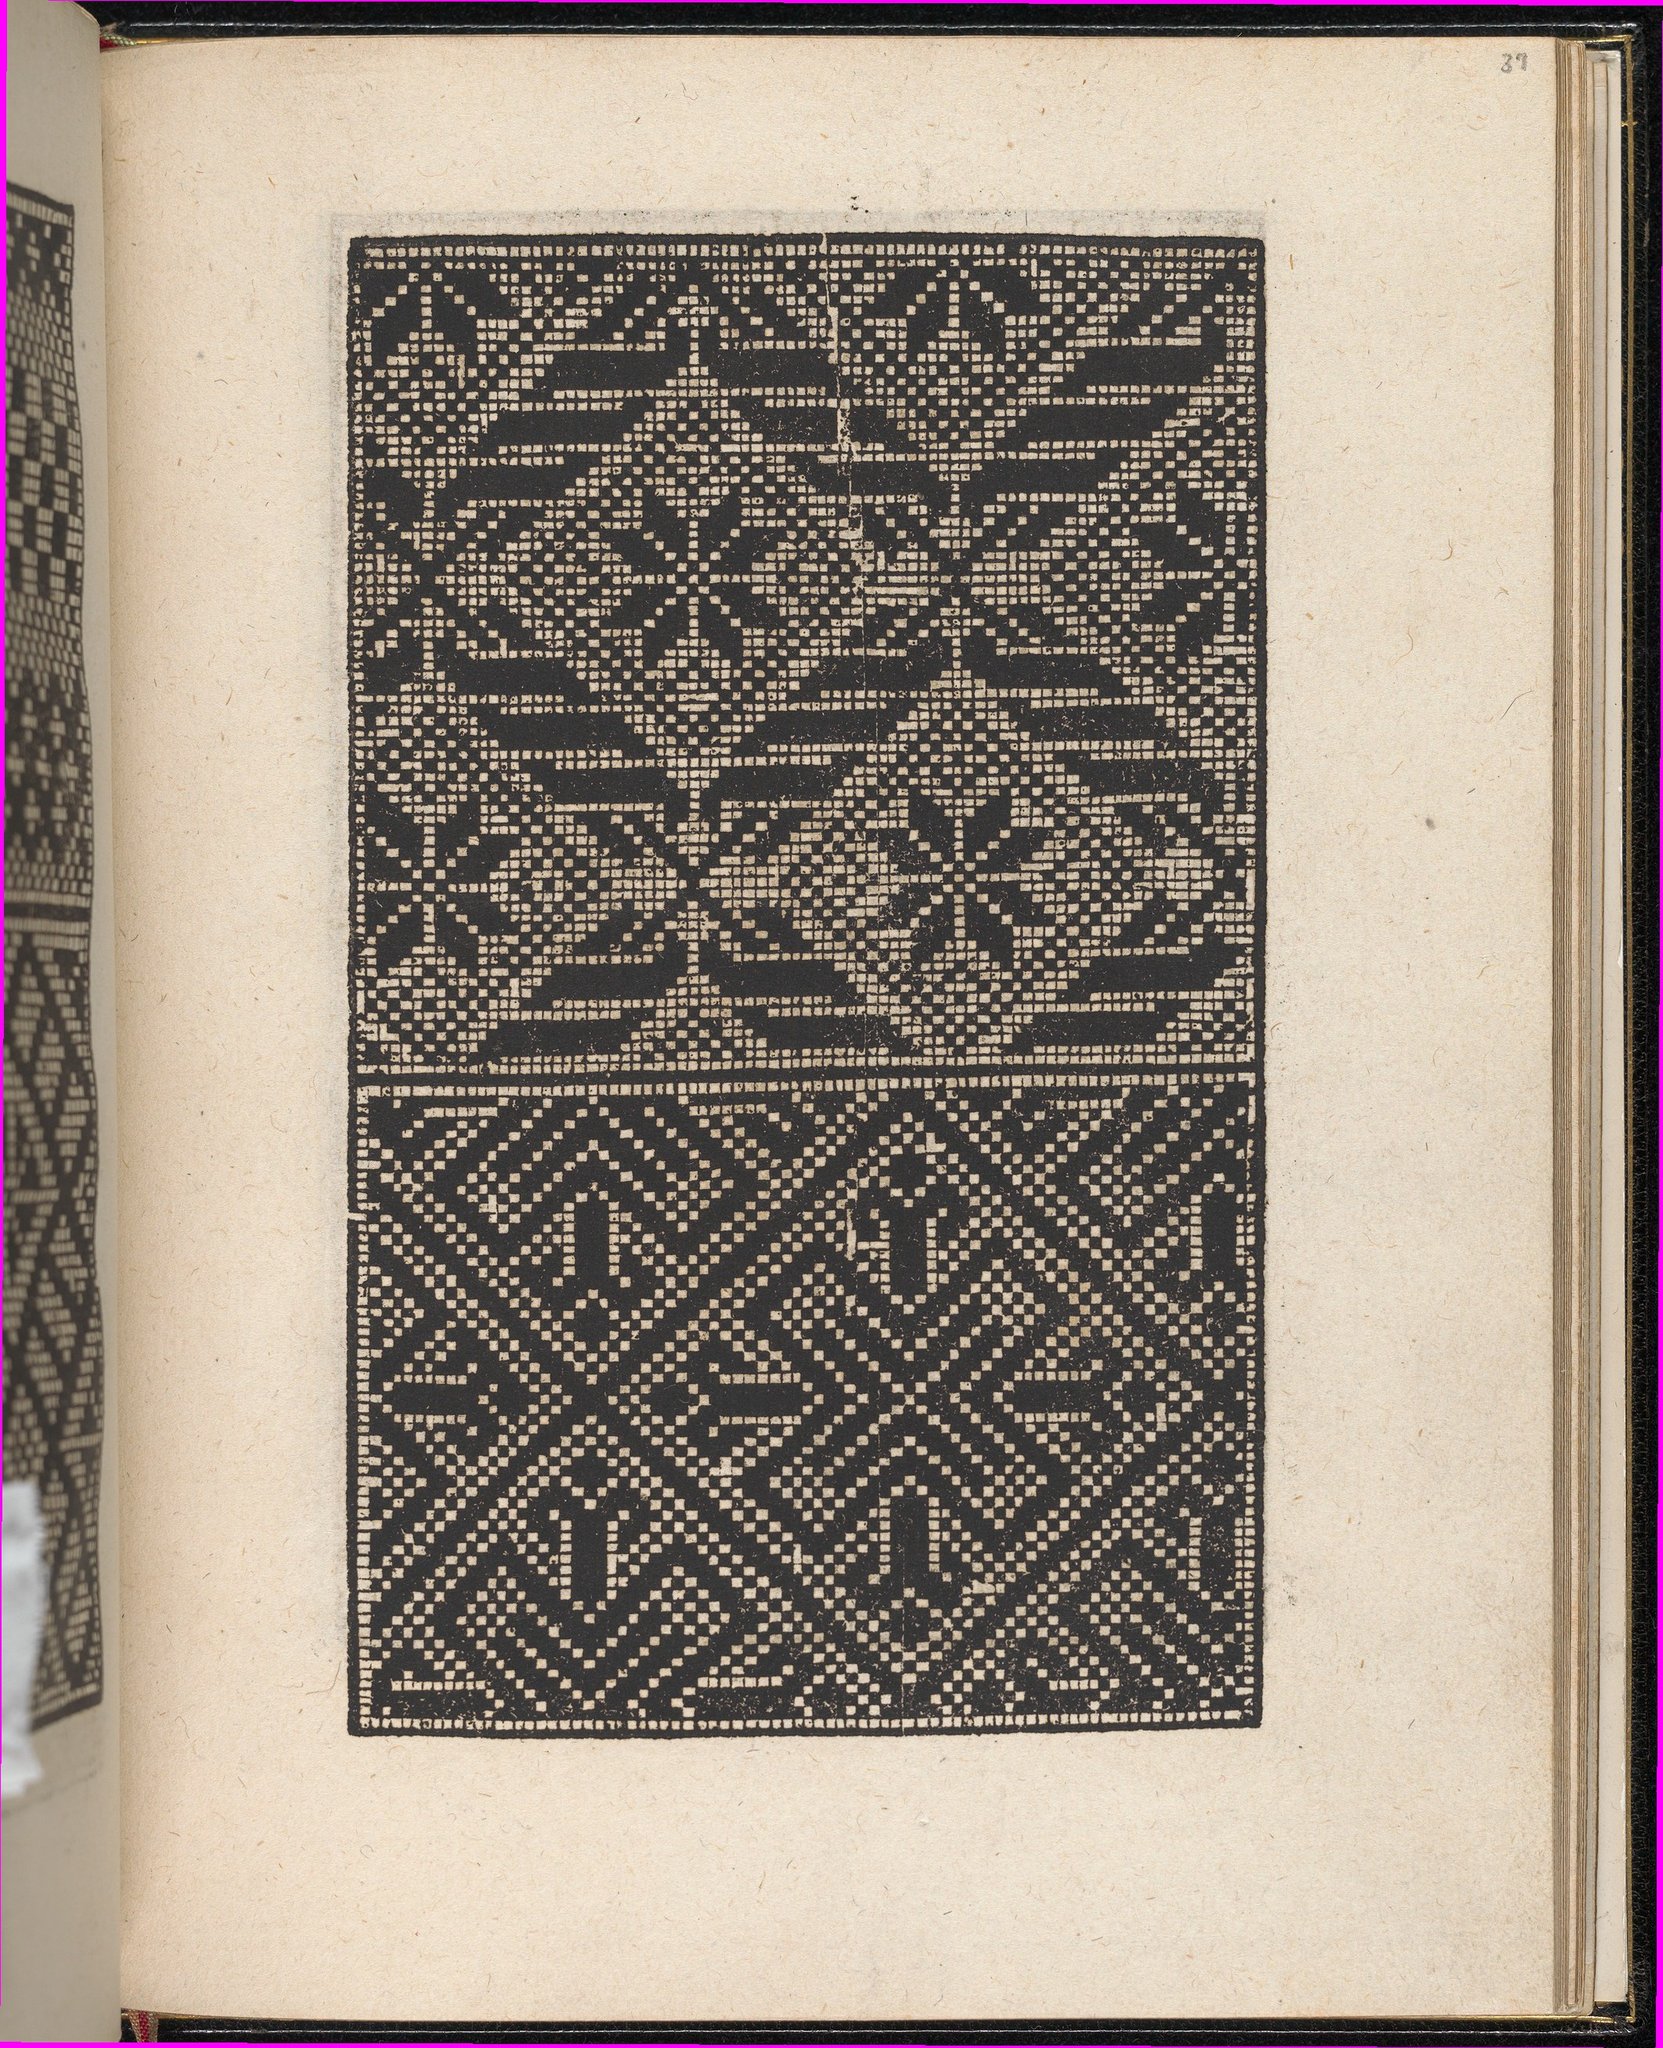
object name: book print ornament architecture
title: Page from Ein new kunstlich Modelbuch...(Page 37r)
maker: peter quentel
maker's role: publisher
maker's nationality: german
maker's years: 1500-1550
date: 1544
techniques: woodcut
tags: ornament